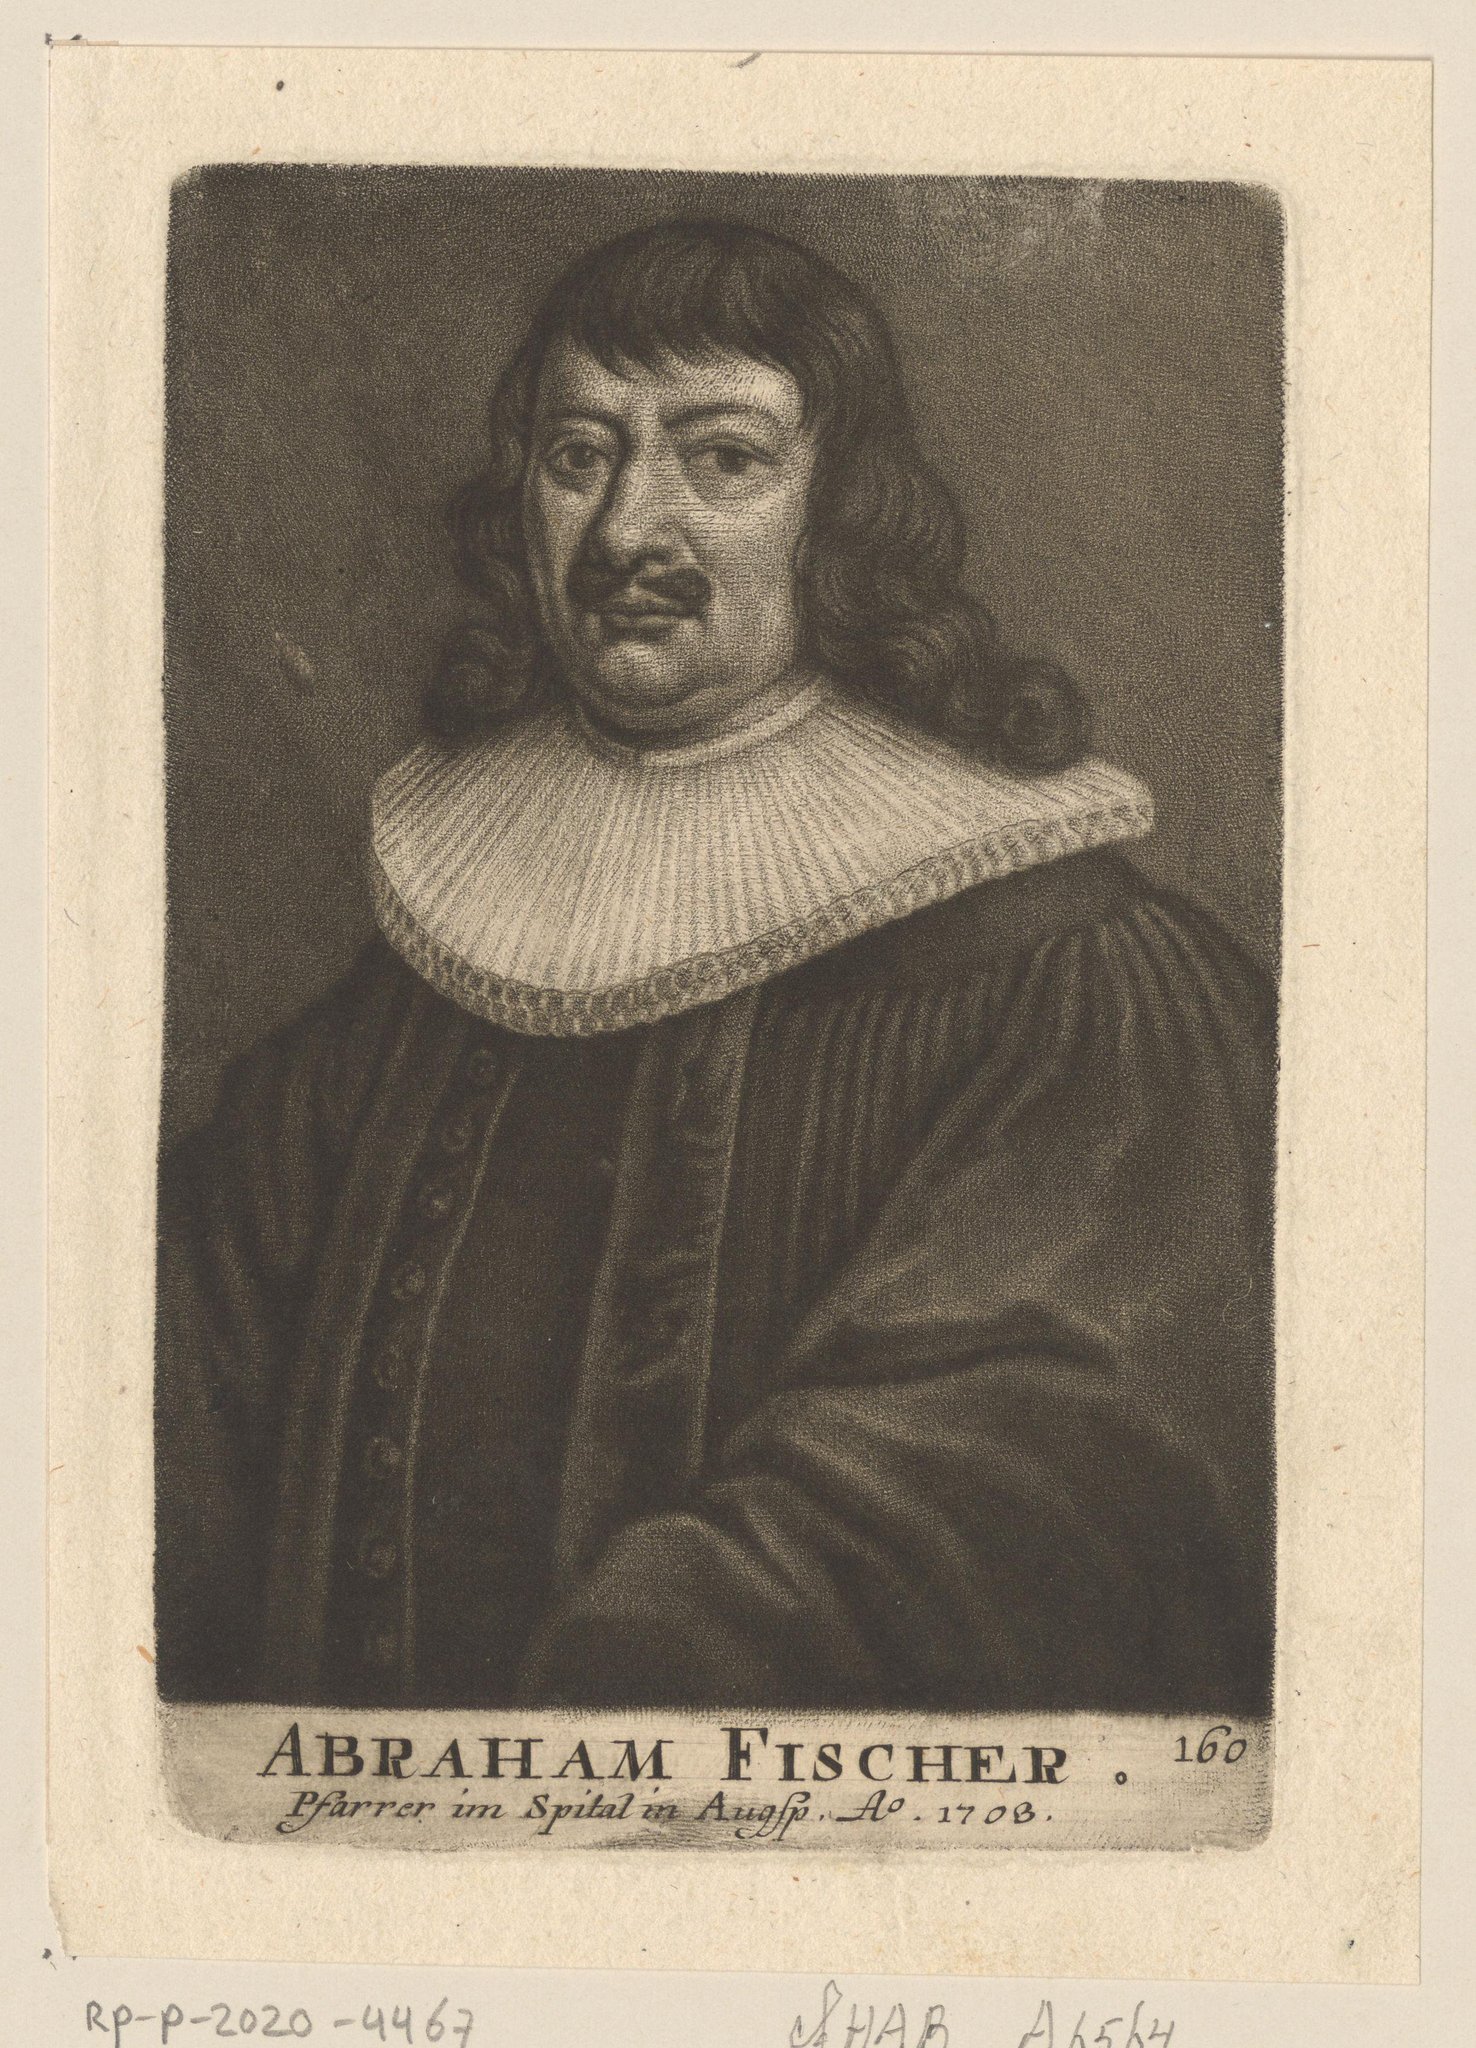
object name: print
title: Portret van Abraham Fischer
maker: Anonymous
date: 1708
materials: paper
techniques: mezzotint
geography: germany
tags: augsburg, abraham fischer, theologian, historical persons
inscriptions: date